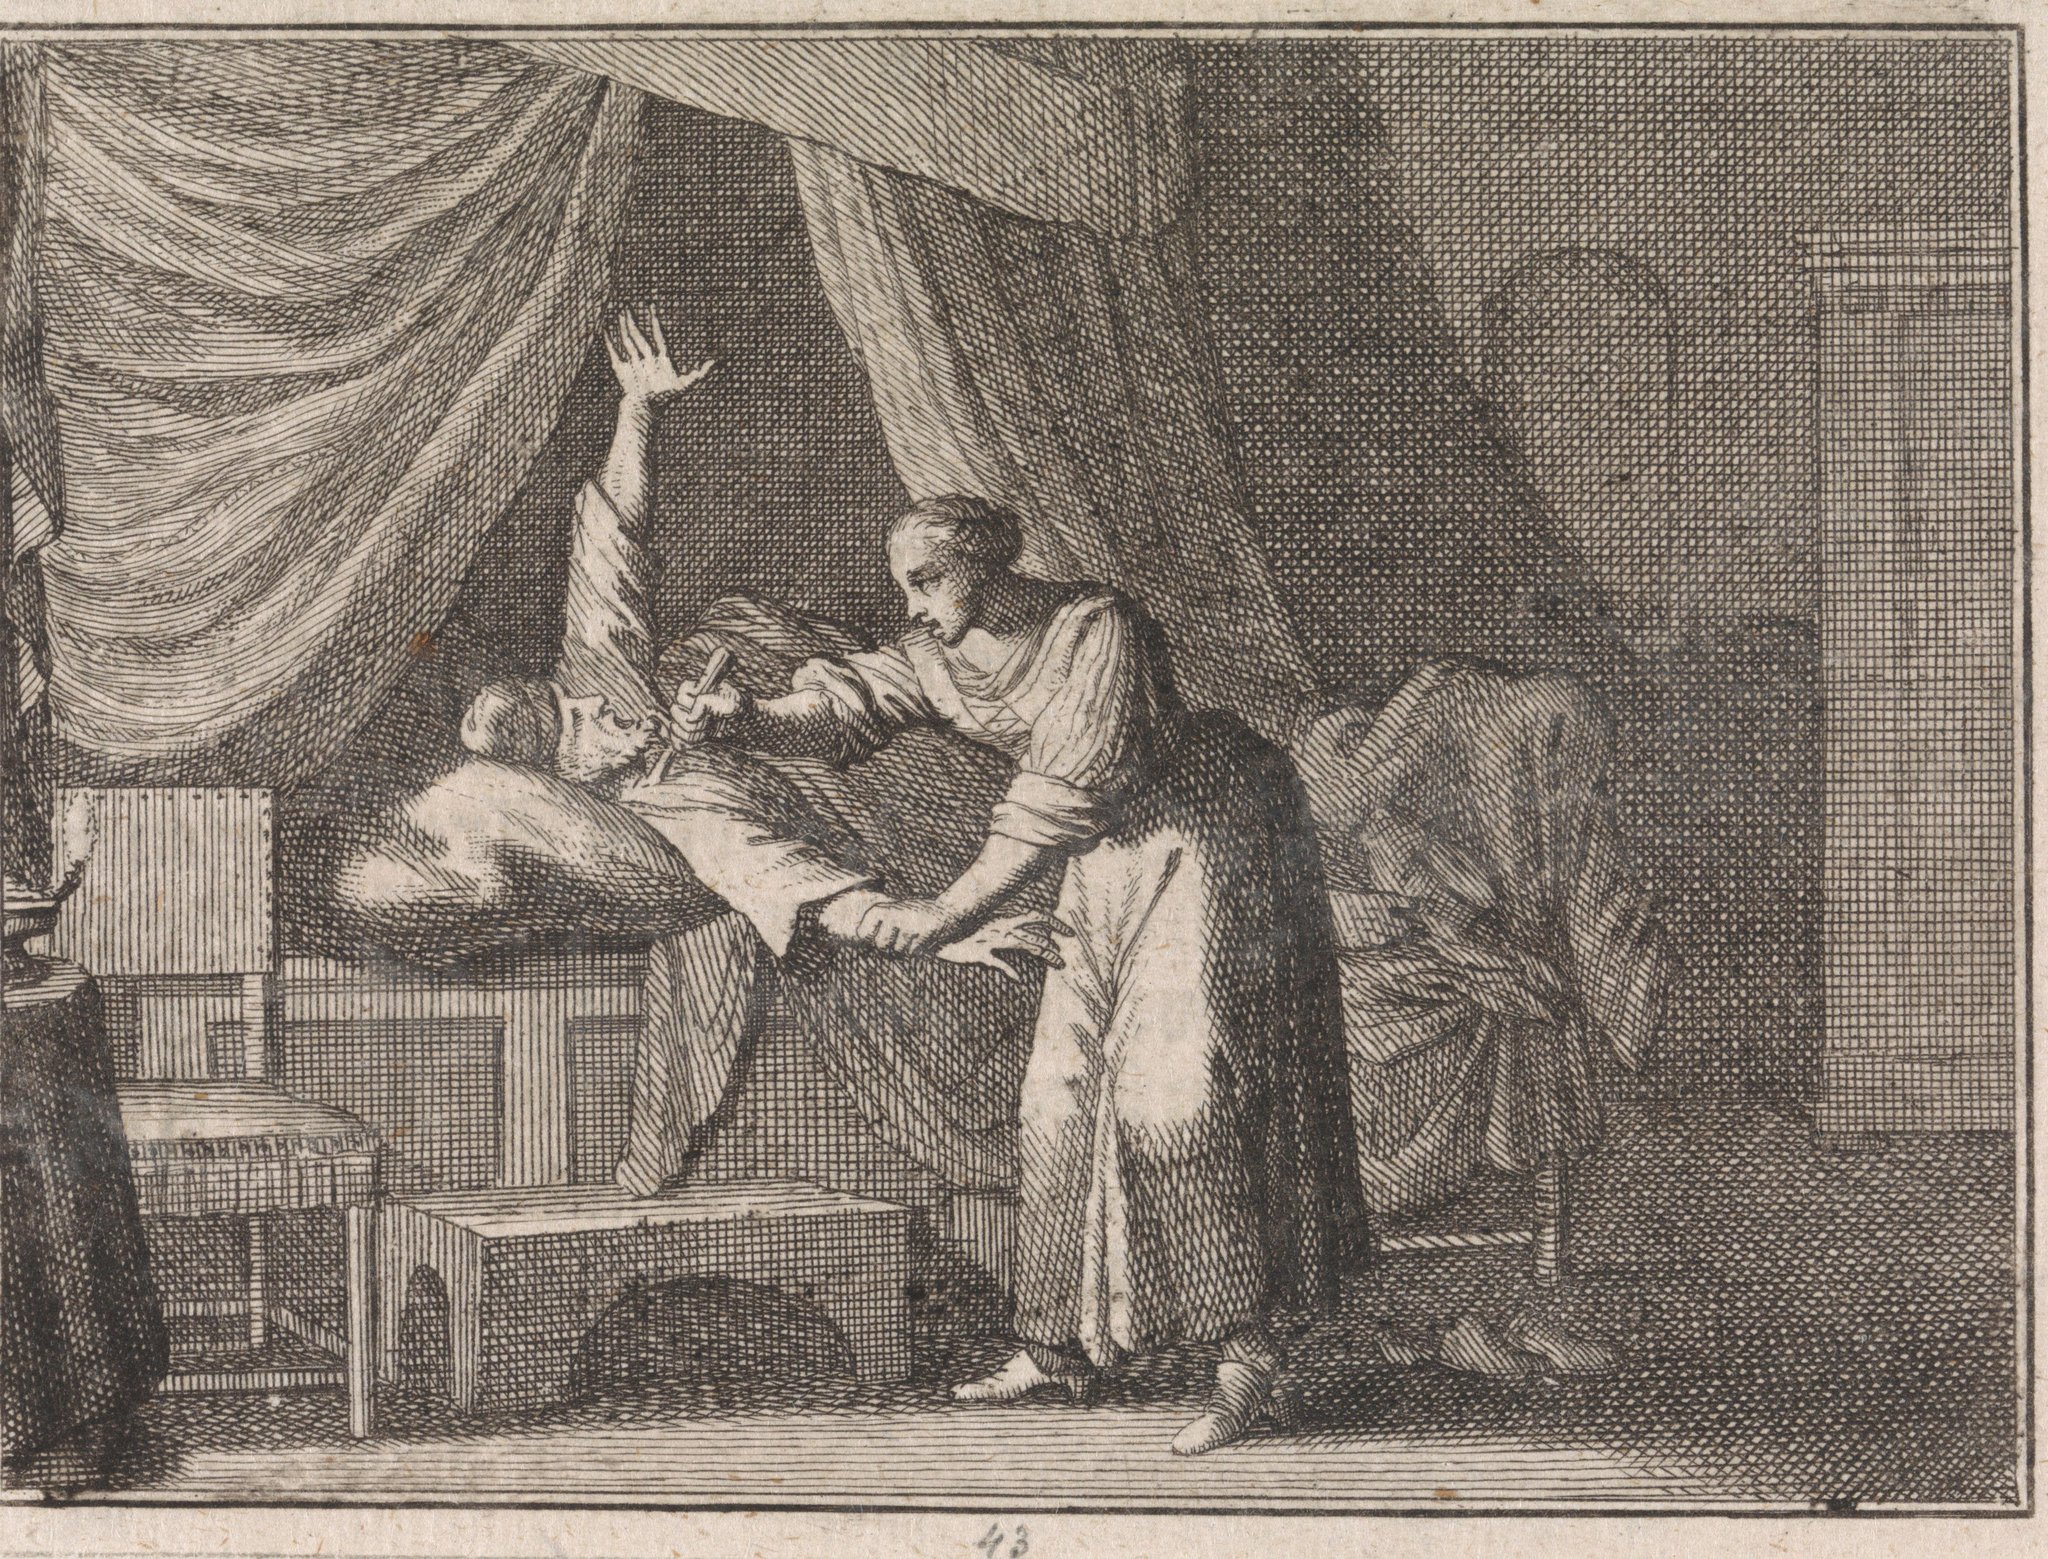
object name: print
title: Das unverantwortliche von Dem zu Der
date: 1710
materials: paper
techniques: etching, letterpress printing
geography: nuremberg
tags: violent death by dagger, knife, violent death, being killed; being mishandled and maltreated; seeking death (+ death by murder)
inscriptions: collector's mark: Lugt 2228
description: Illustratie uit: Abraham a Sancta Clara. Heilsames Gemisch Gemasch, das ist: Allerley seltsame und verwunderliche Geschichten (...). Neurenberg: Christoph Weigel, 1710, p. 430.